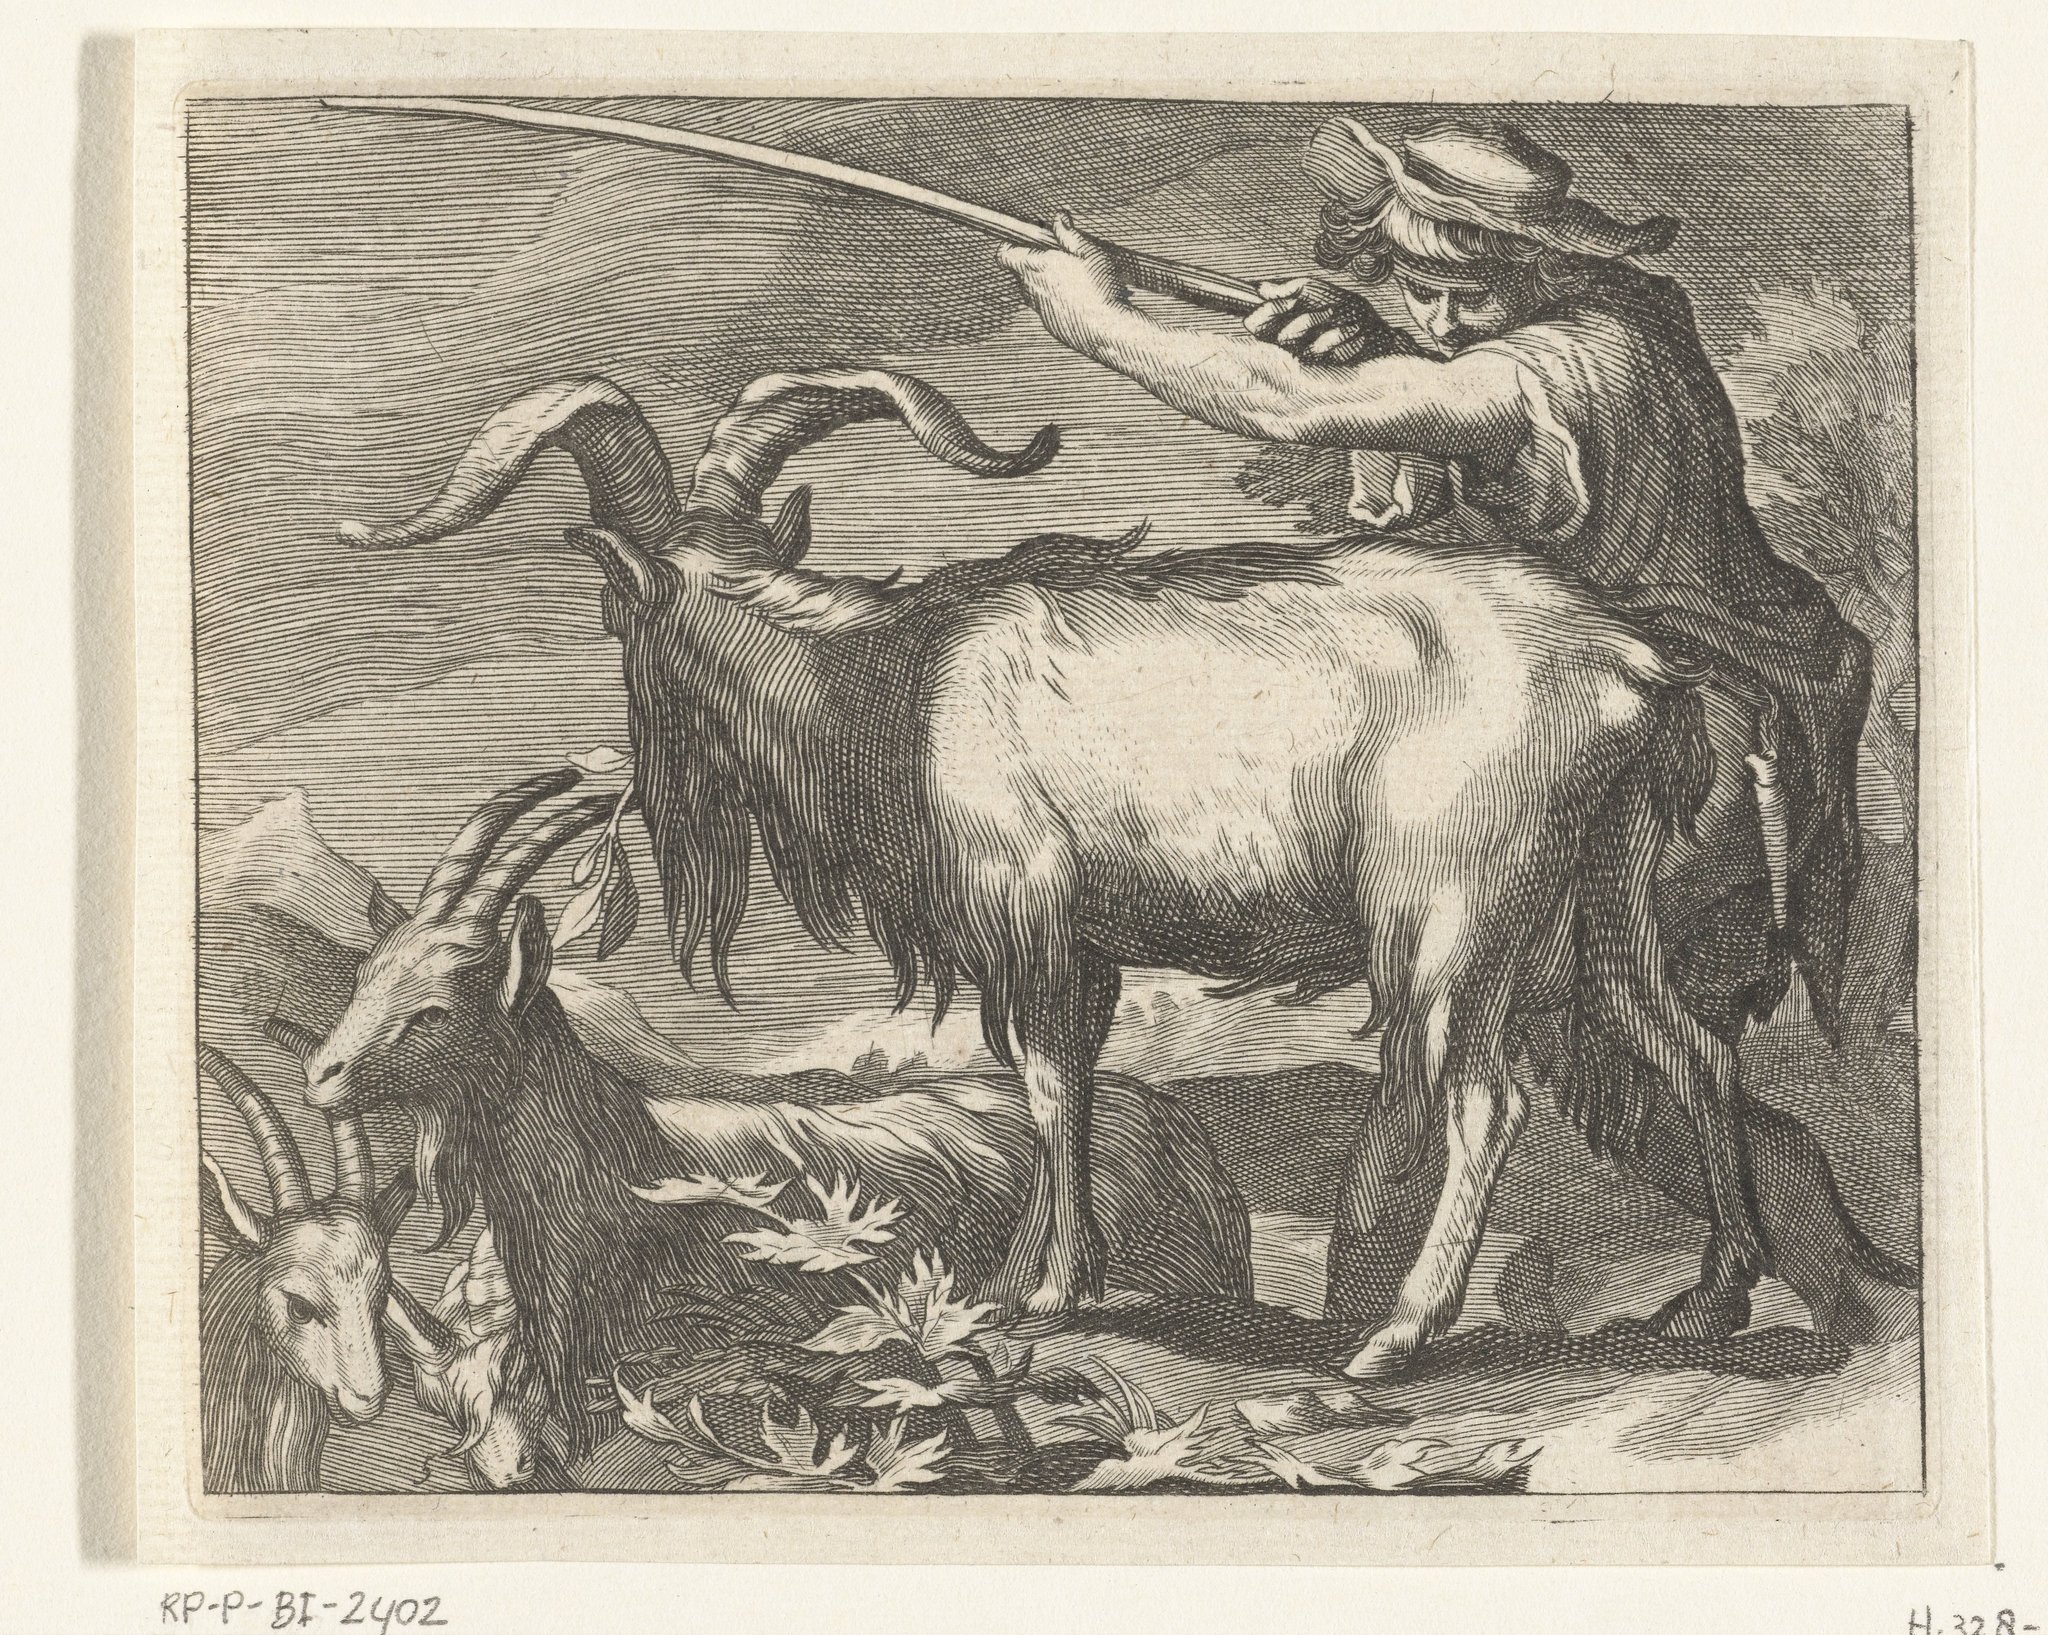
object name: print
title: Pastoralen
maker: Anonymous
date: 1611-1661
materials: paper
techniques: engraving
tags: herding, herdsman, herdswoman, shepherd, shepherdess, cowherd, etc., goat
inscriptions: collector's mark: Lugt 2228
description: Kopie in spiegelbeeld naar prent uit serie met veertien prenten zogenaamde Pastoralen van B.A. Bolswert naar ontwerp van Abraham Bloemaert.